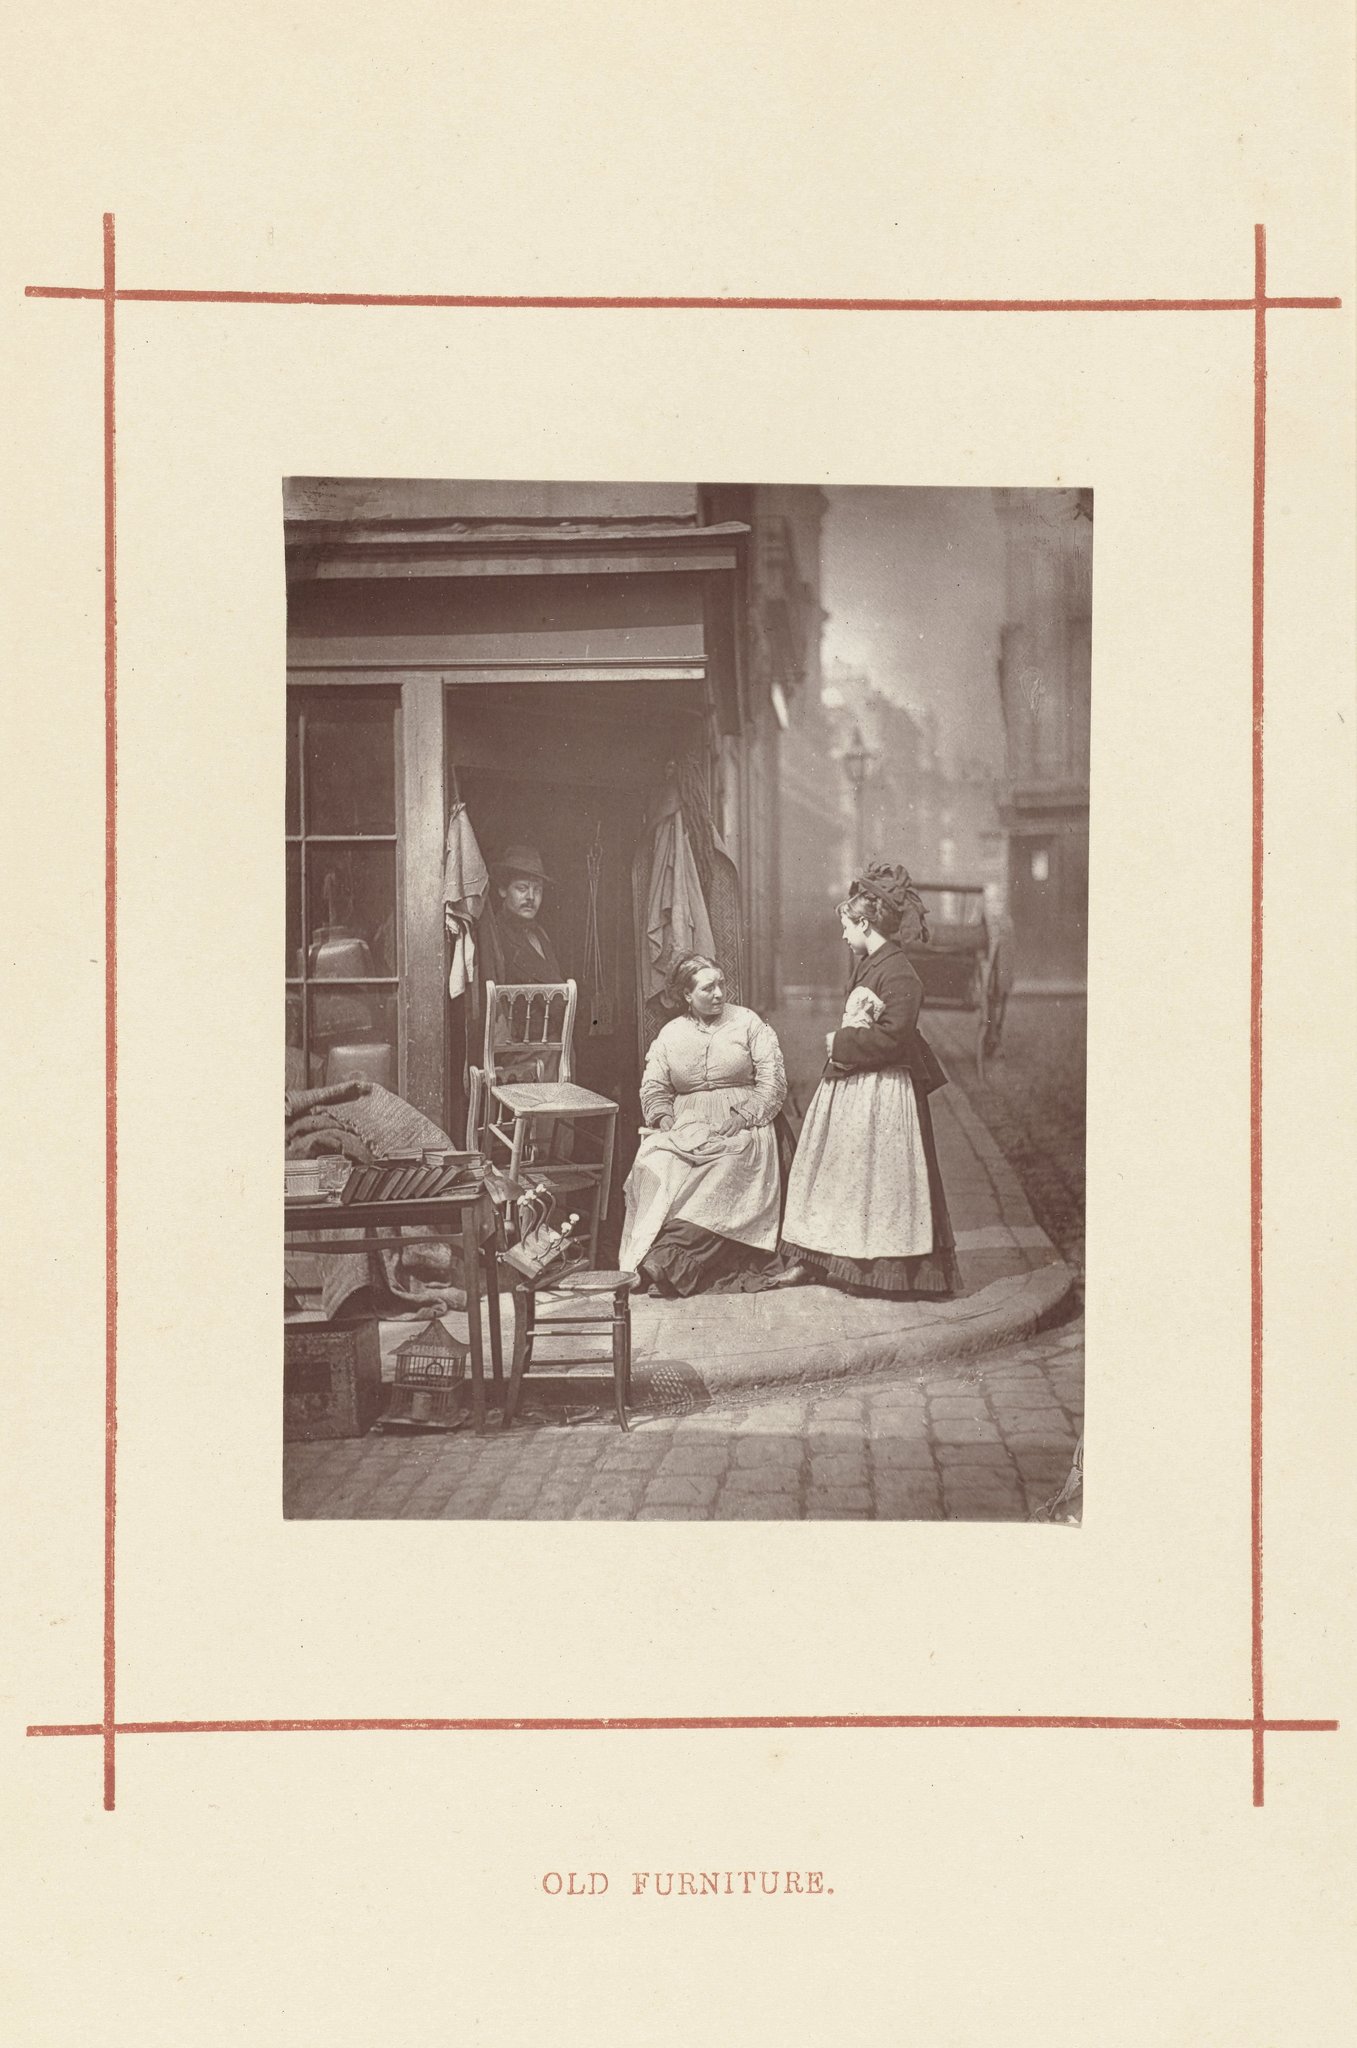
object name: photomechanical print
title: Old Furniture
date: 1876-1878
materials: cardboard, paper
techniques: woodburytype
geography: england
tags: furniture and household effects, london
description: Plaat uit dit boek J. Thomson en Adolphe Smith, Street Life in London, Part 12 (1st January, 1878).